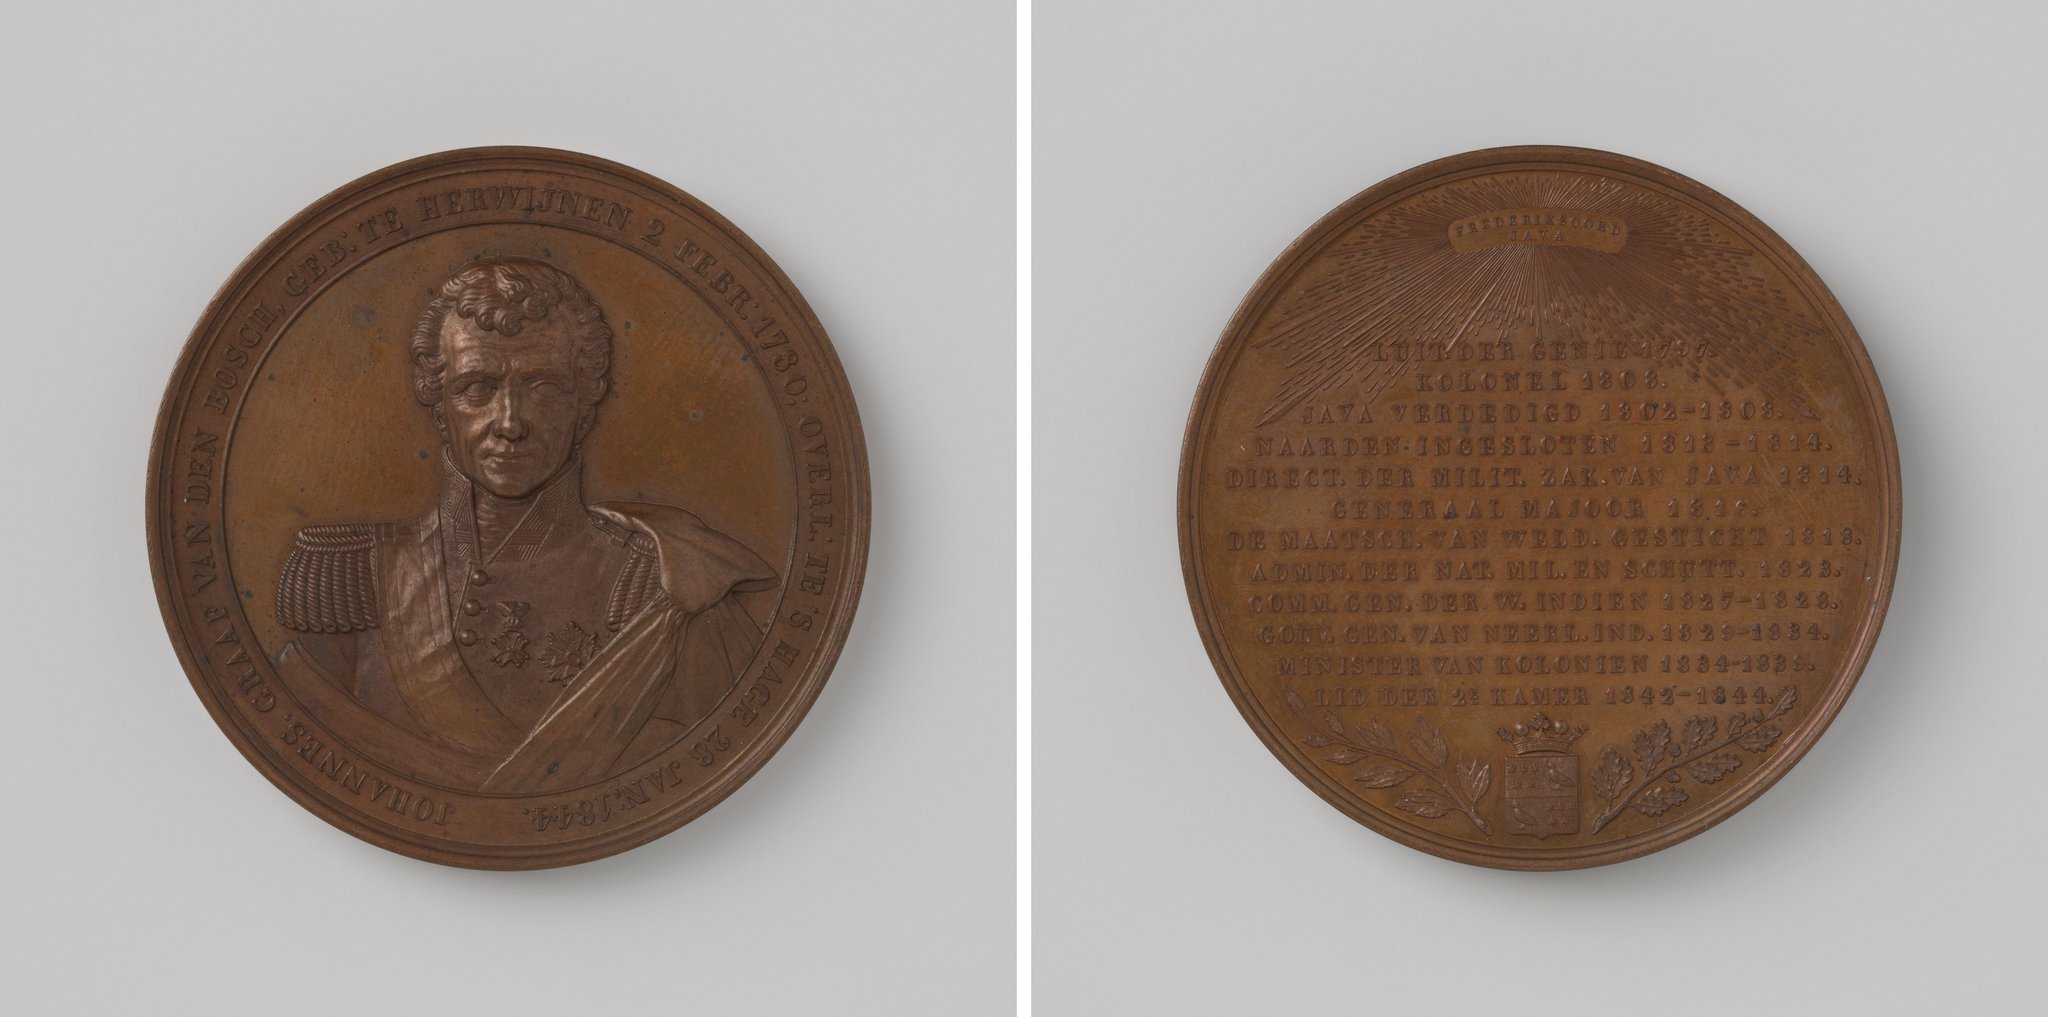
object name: history medal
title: Overlijden van Johannes graaf van den Bosch 1844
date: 1844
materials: bronze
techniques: striking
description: Bronzen penning, op de voorzijde het aanziende geuniformeerde borstbeeld van Van den Bosch met omschrift, op de keerzijde twaalf regels tekst, bovenaan een stralend opschrift, onderaan een gekroond wapenschildje tussen een lauwer- en eikentak.